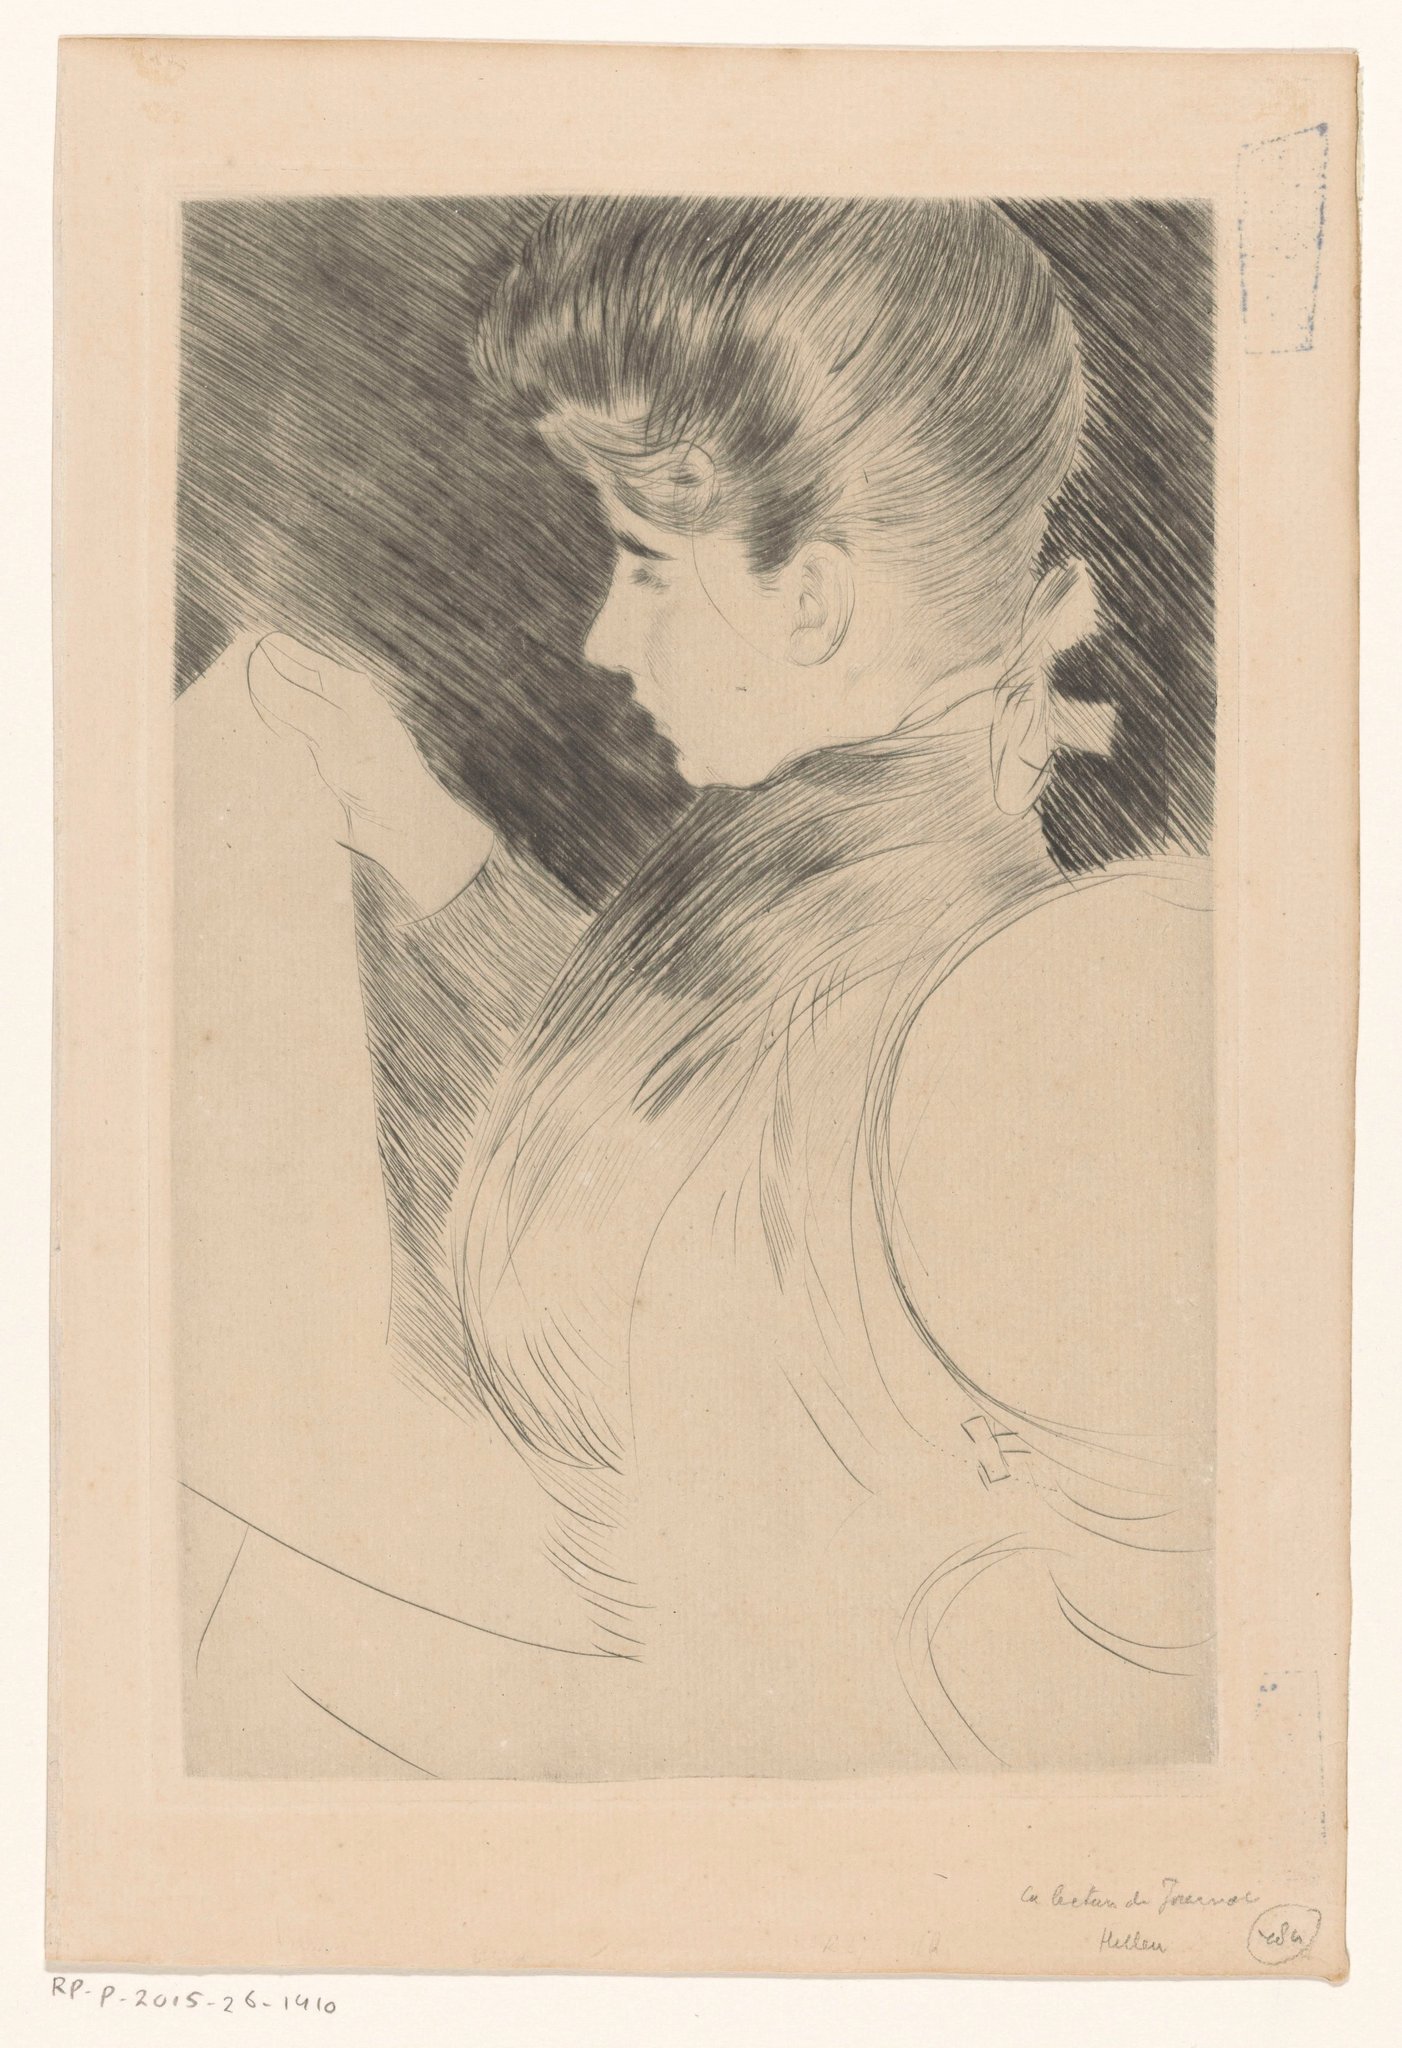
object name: print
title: Lezende vrouw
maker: paul césar helleu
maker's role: draughtsman, painter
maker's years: 1859-1927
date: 1869-1927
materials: paper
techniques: drypoint, intaglio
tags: reading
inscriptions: collector's mark: Lugt 2228, annotation: ‘la lecture du journal / helleu’, collector's mark: Lugt 4779